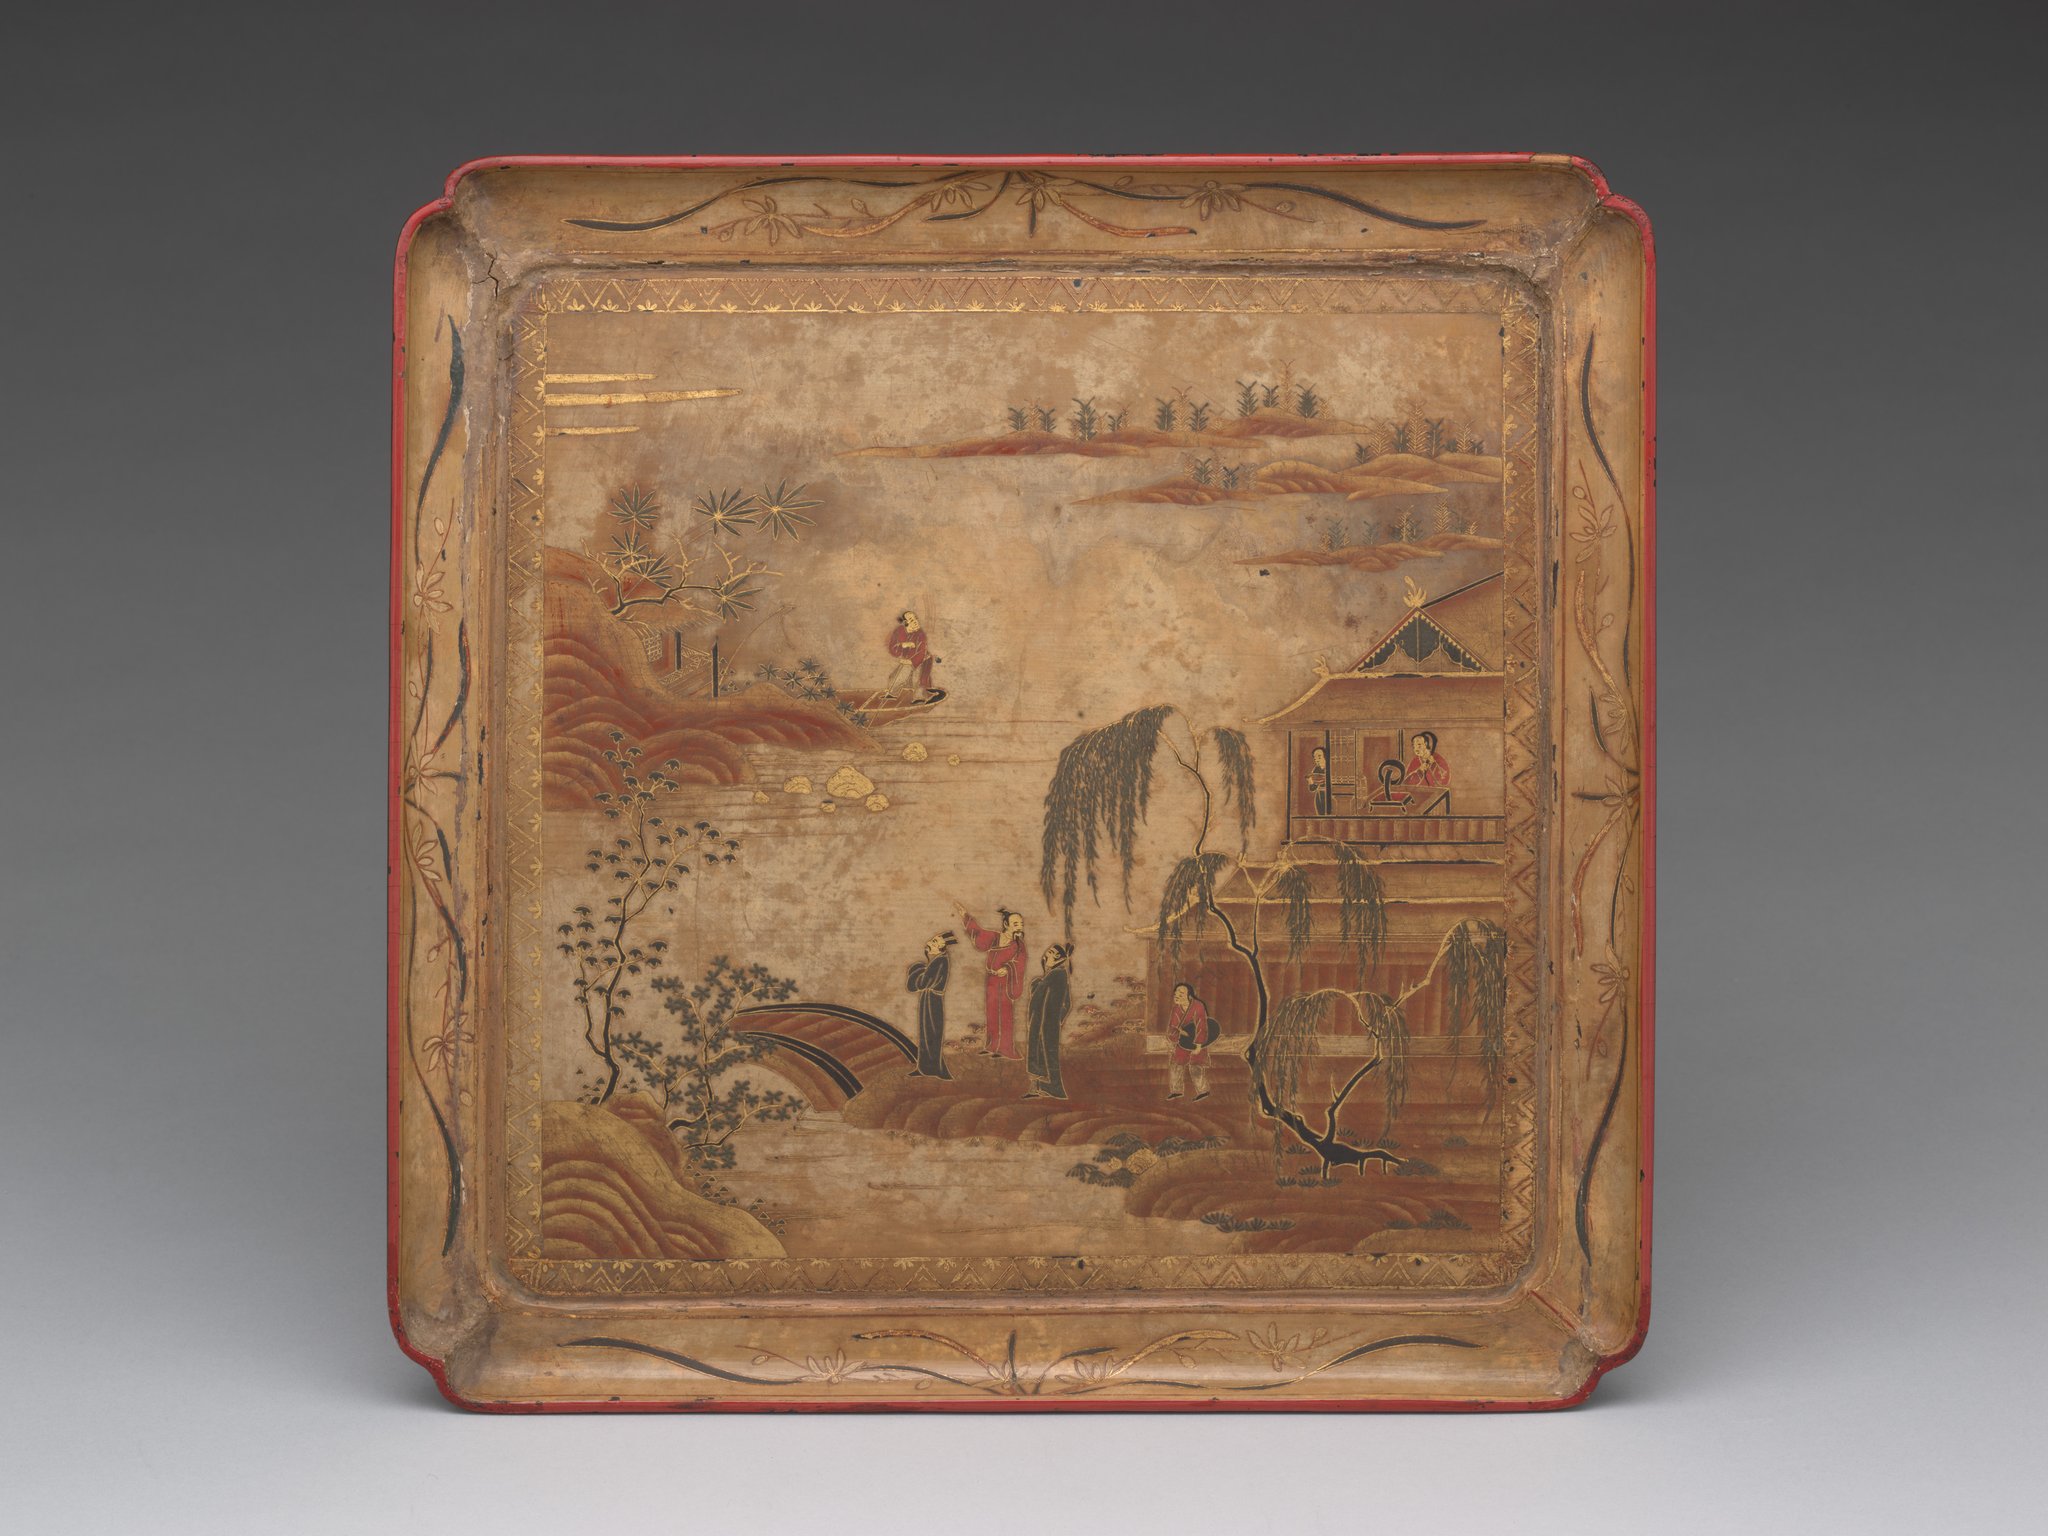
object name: tray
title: Square Tray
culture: japanese or ryukyuan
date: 1601-1800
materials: gold, lacquer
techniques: painting